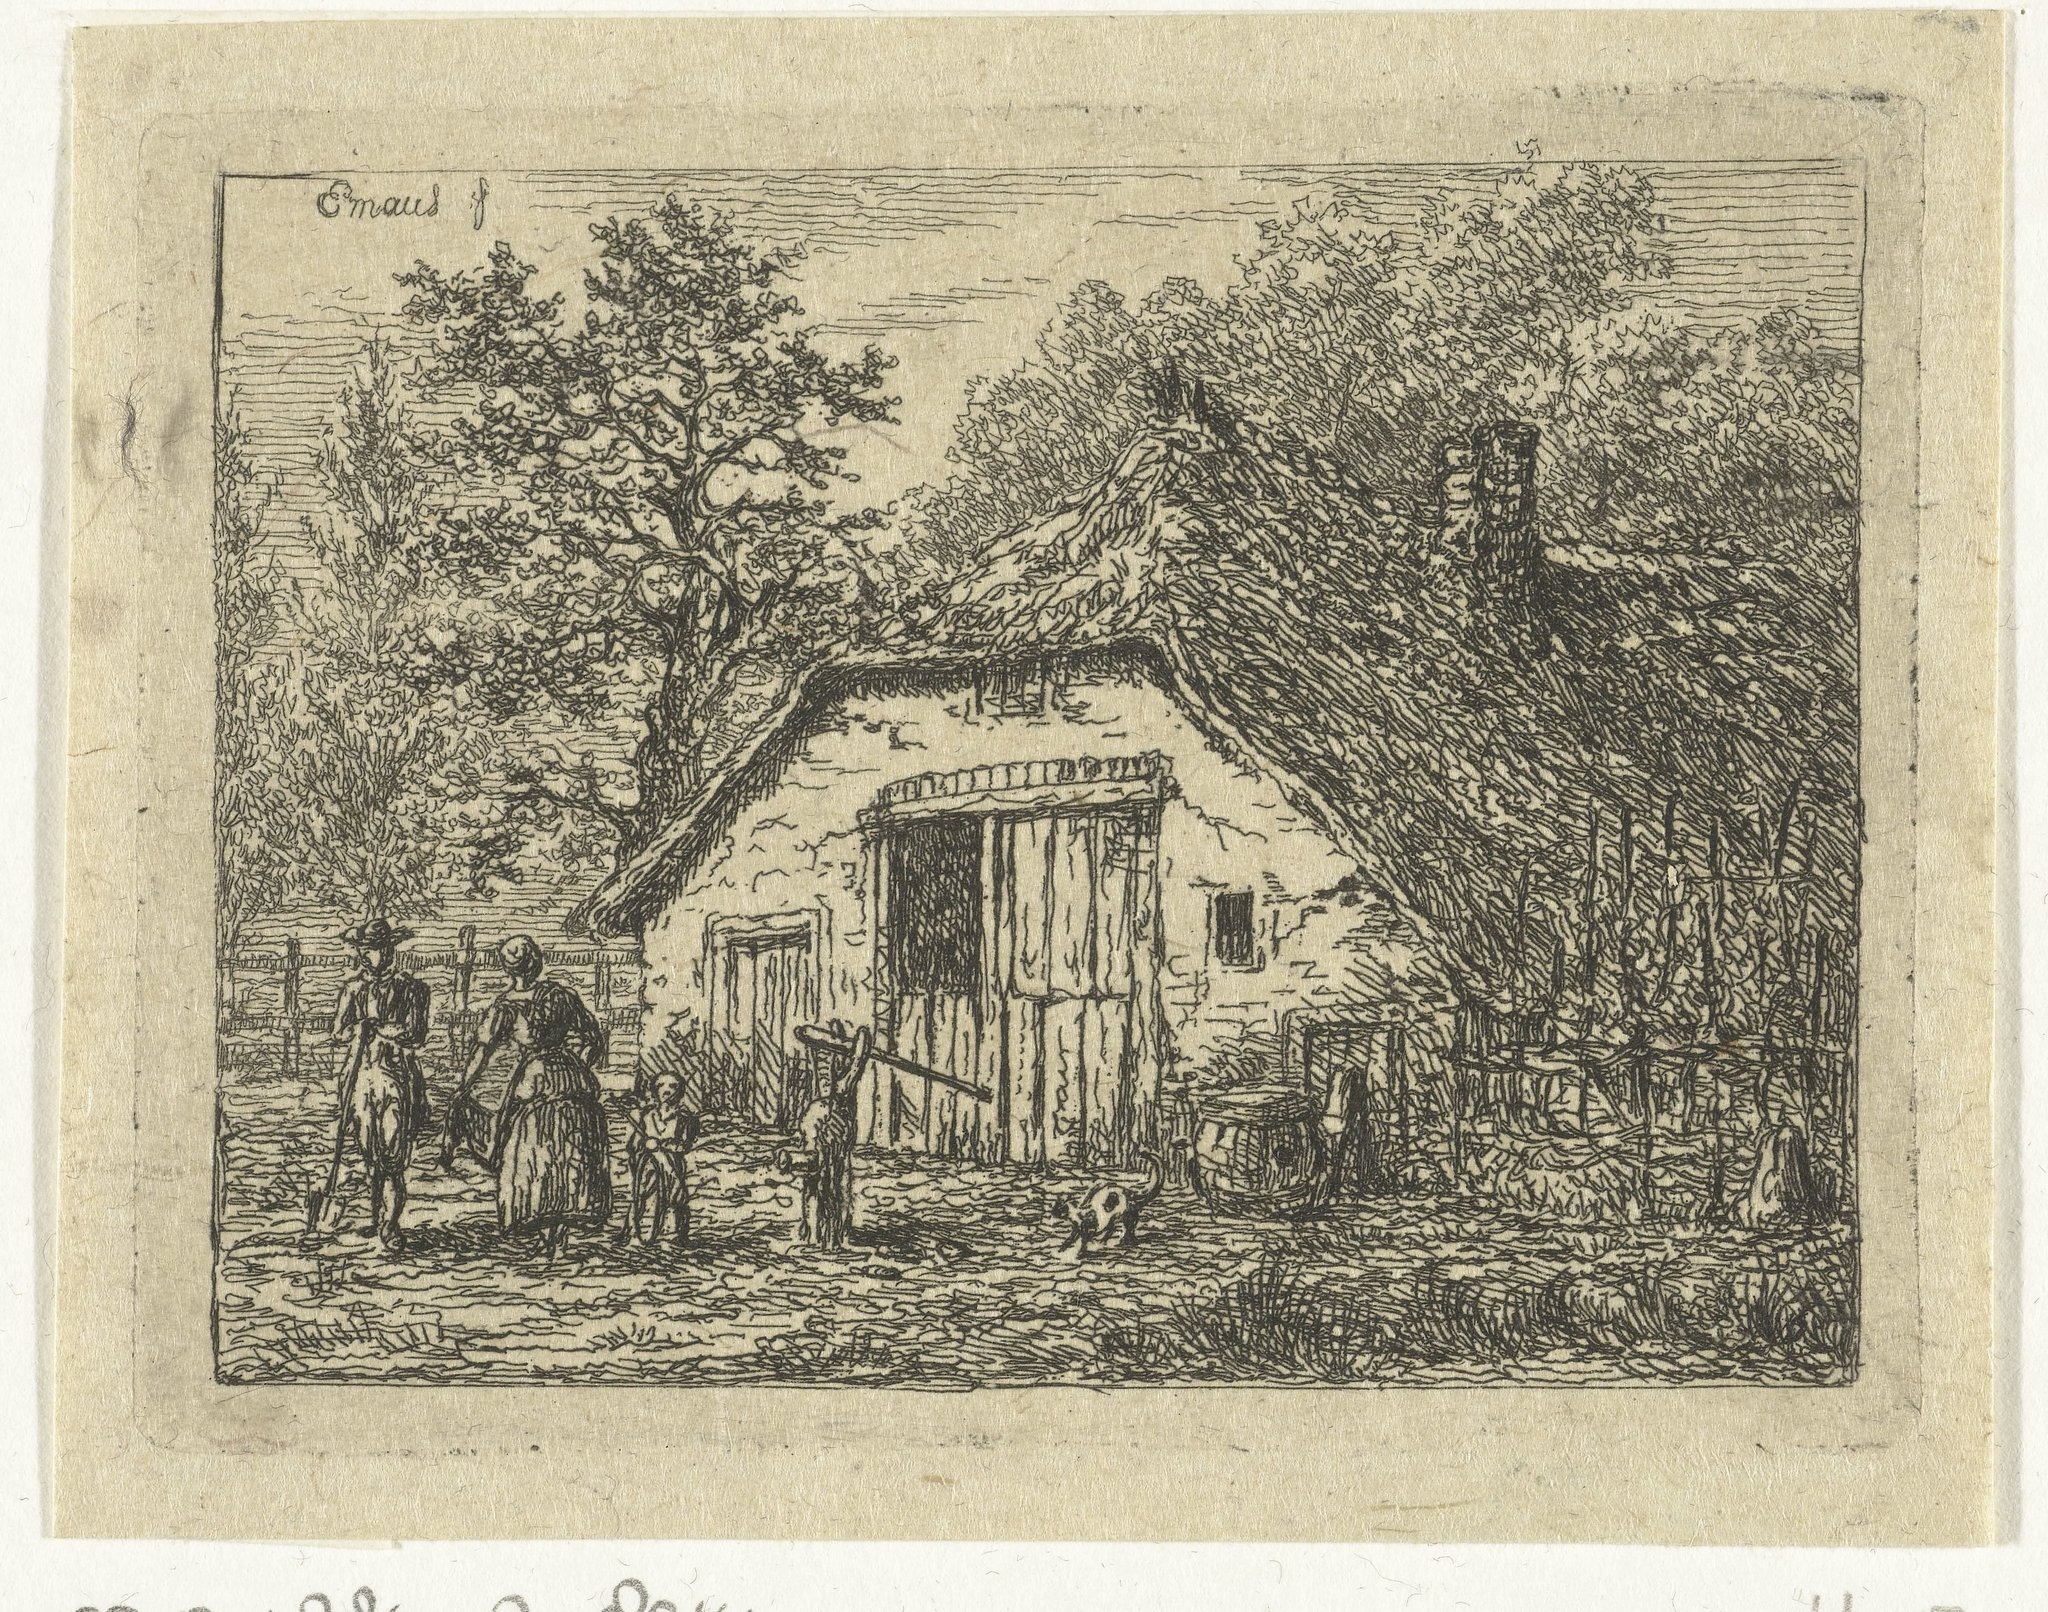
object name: print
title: De hovenier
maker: gerardus emaus de micault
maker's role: draughtsman, print maker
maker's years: 1798-1863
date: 1813-1863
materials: paper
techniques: etching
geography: netherlands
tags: barn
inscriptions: collector's mark: Lugt 2228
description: Bij een plaggenhut staan een man, vrouw en een kind; de man heeft een schep vast en de vrouw draagt een mand. Naast de waterpomp loopt een kat.